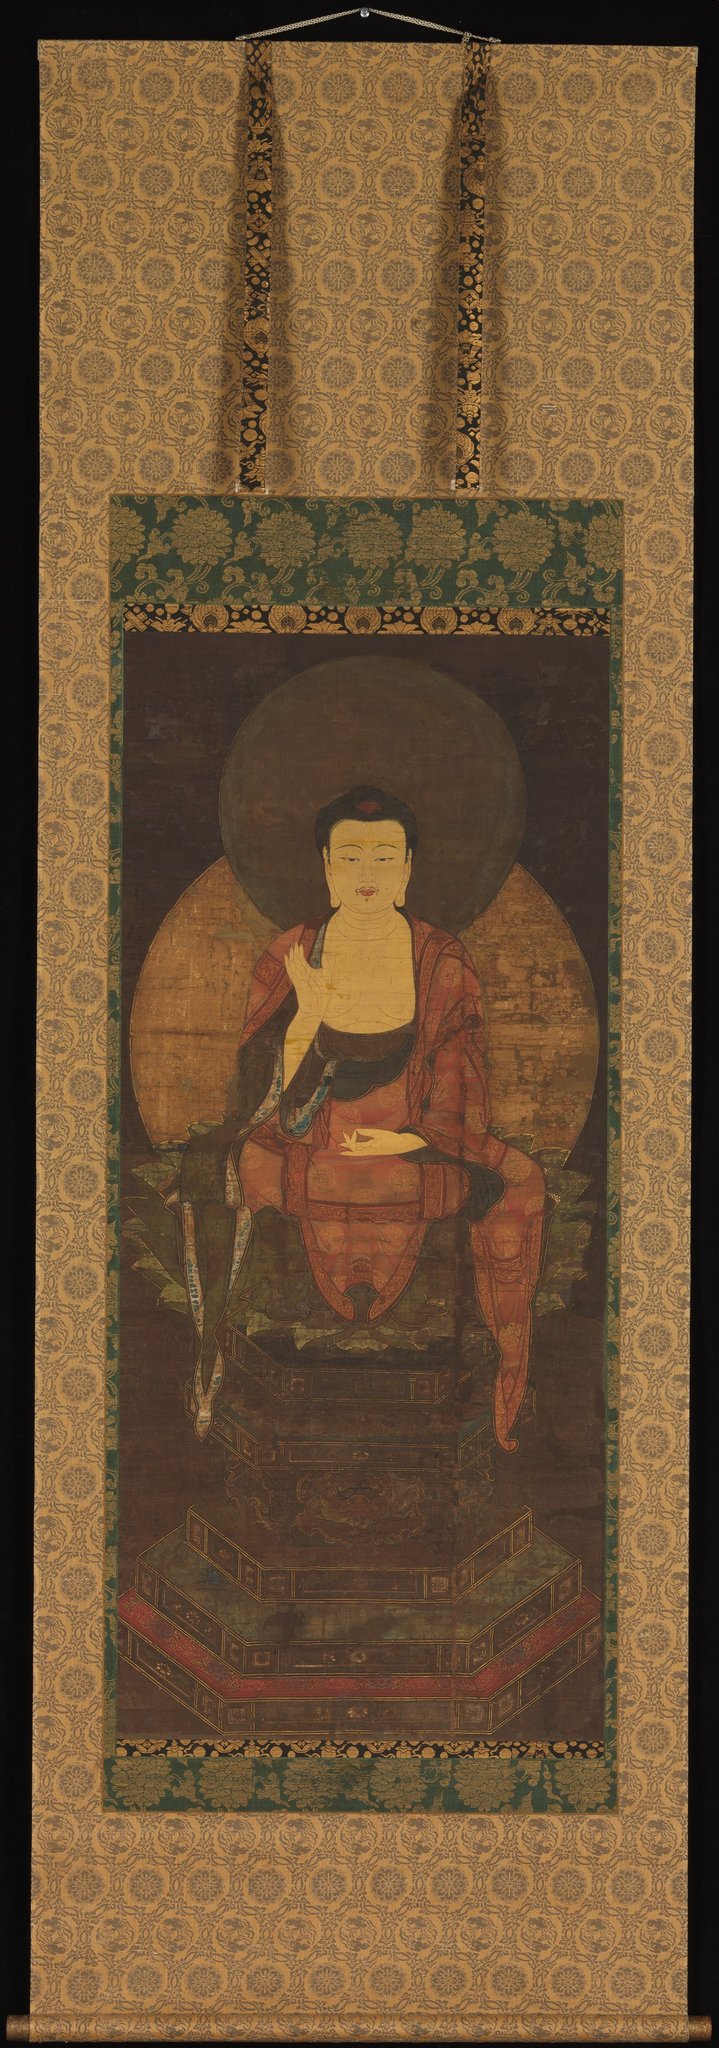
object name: hanging scroll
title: Shaka Nyorai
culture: japanese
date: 1301-1400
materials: gold, ink, silk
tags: buddhism,shakyamuni